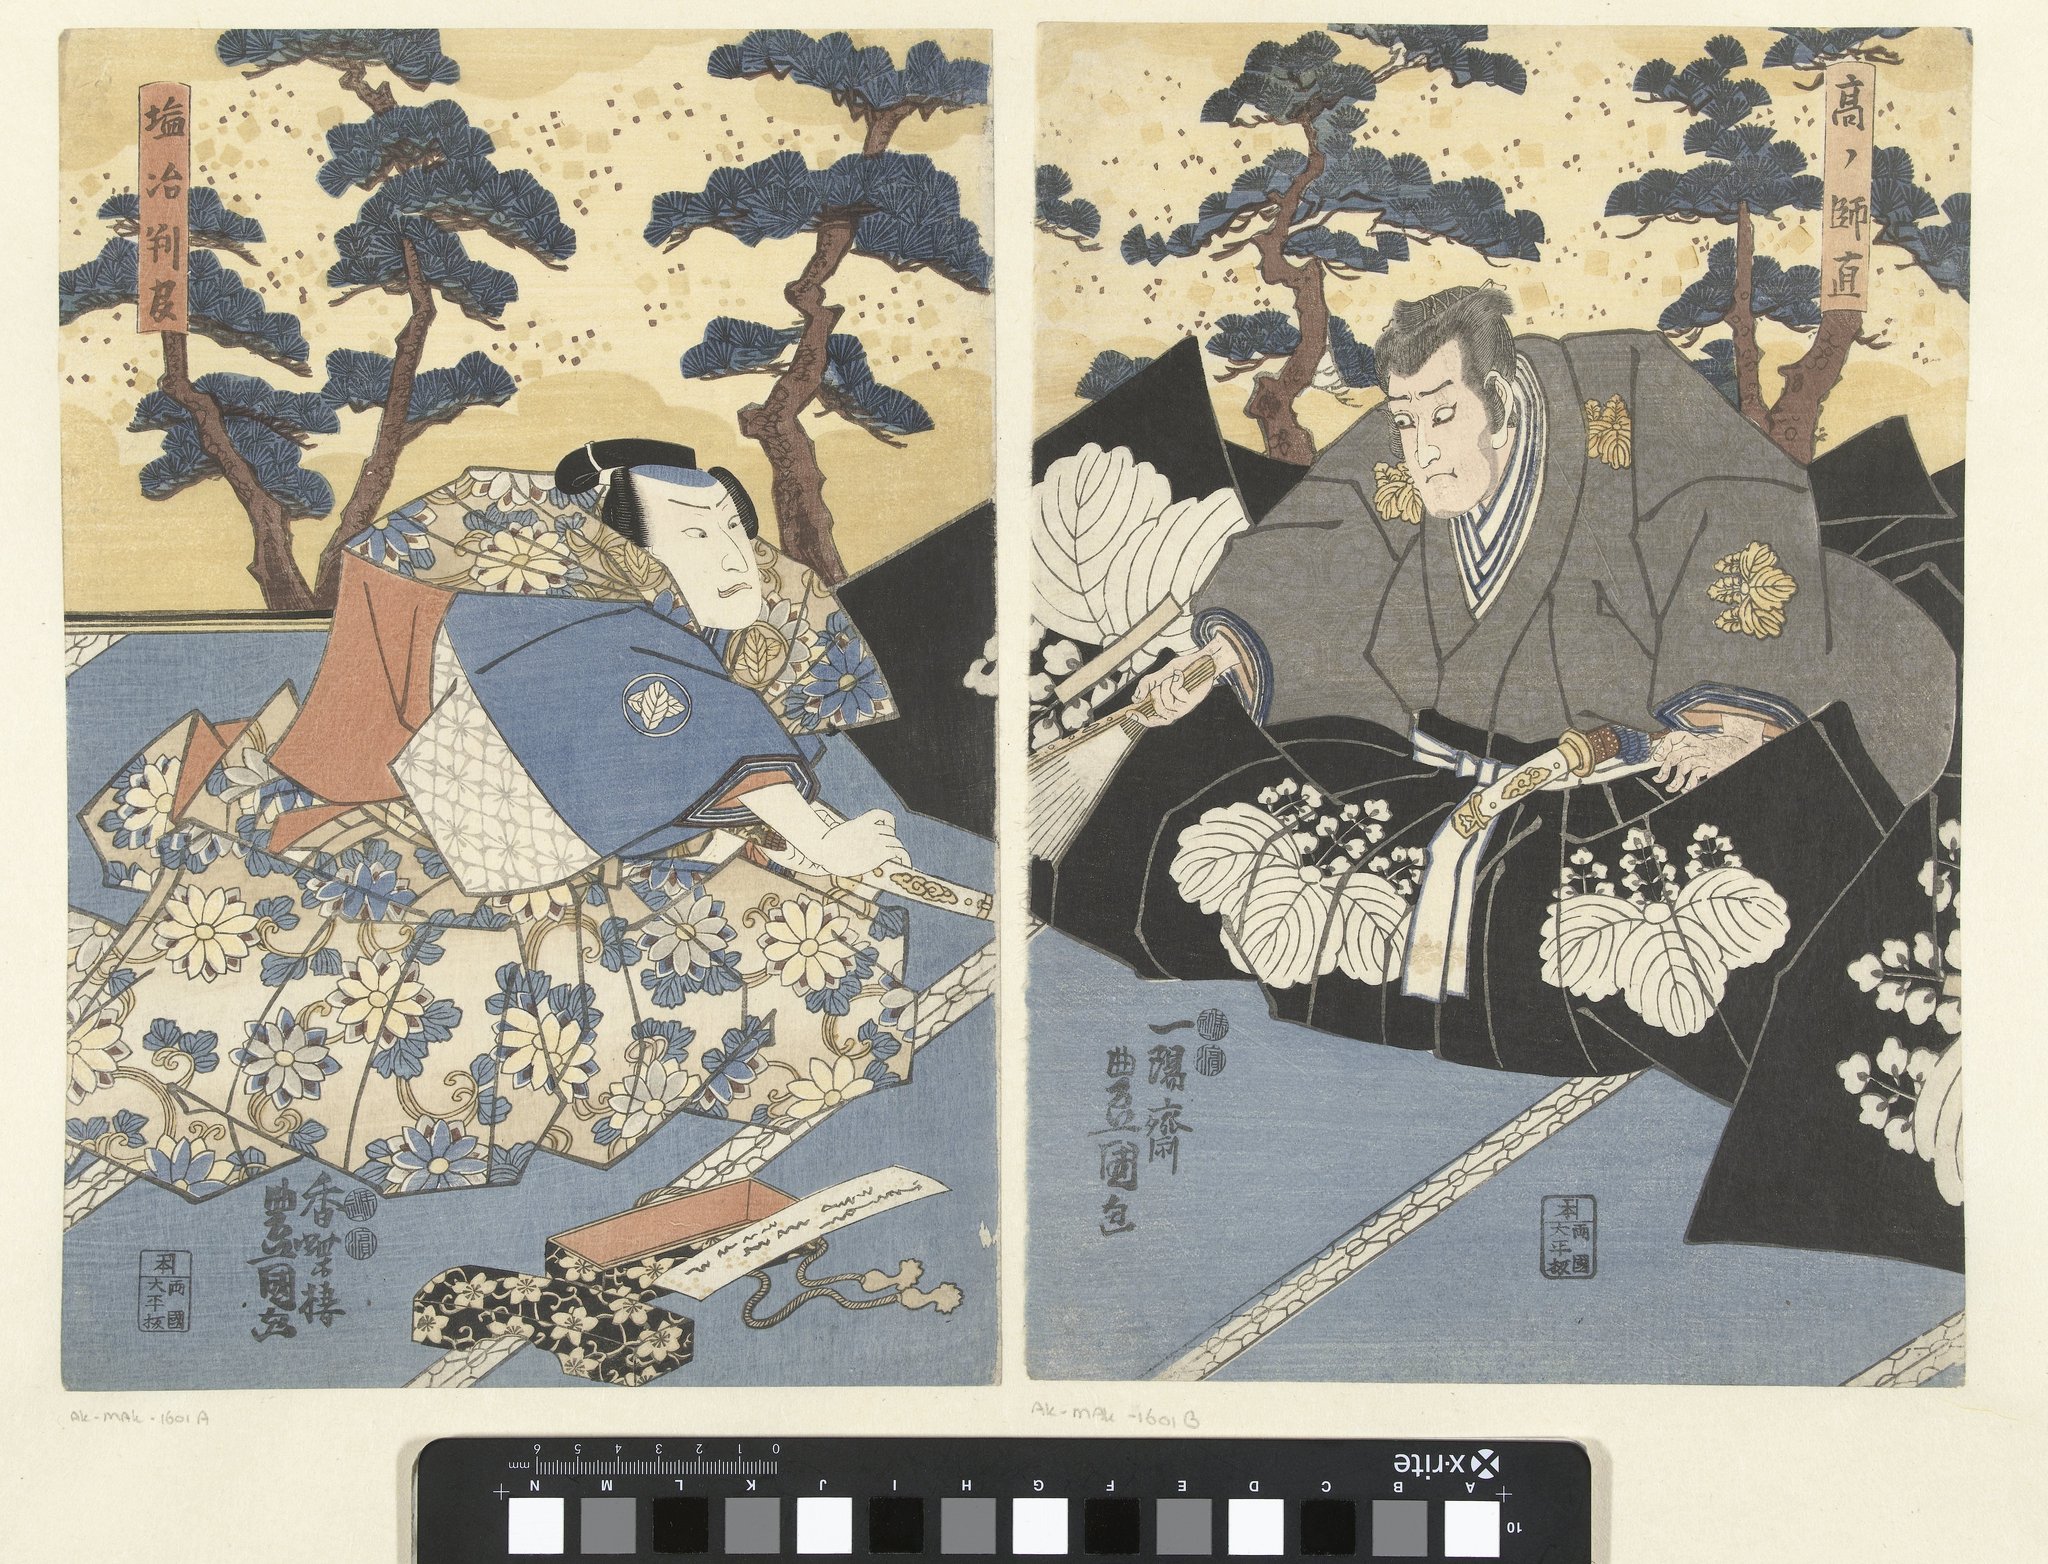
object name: print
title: Twee acteurs als hovelingen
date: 1849-1853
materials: paper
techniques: woodcut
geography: tokyo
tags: hacking and thrusting weapons: sword, portrait of actor, actress, screen, folding screen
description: Twee acteurs, zittend met waaier en zwaard, in kamer met goudkleurig kamerscherm met schildering van pijnbomen.